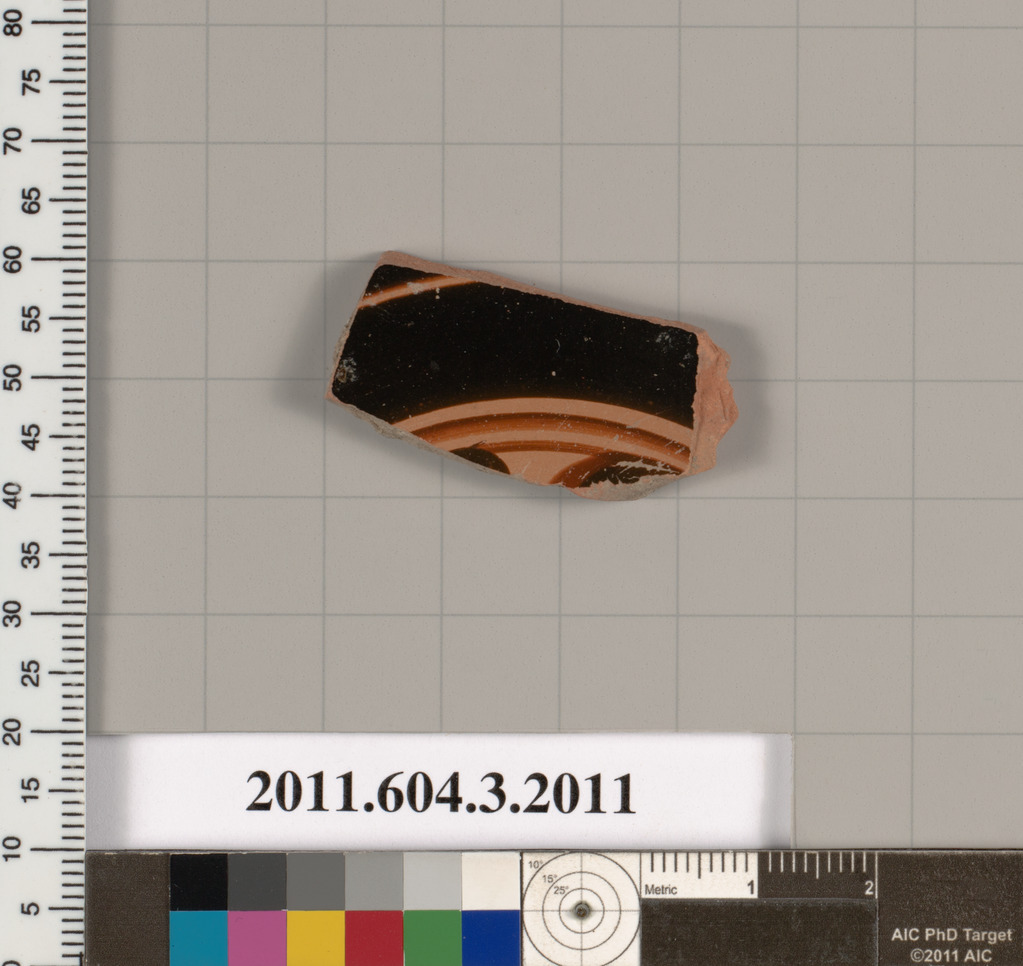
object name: kylix fragment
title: Terracotta fragment of a kylix (drinking cup)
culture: greek, attic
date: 550-526 BCE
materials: terracotta